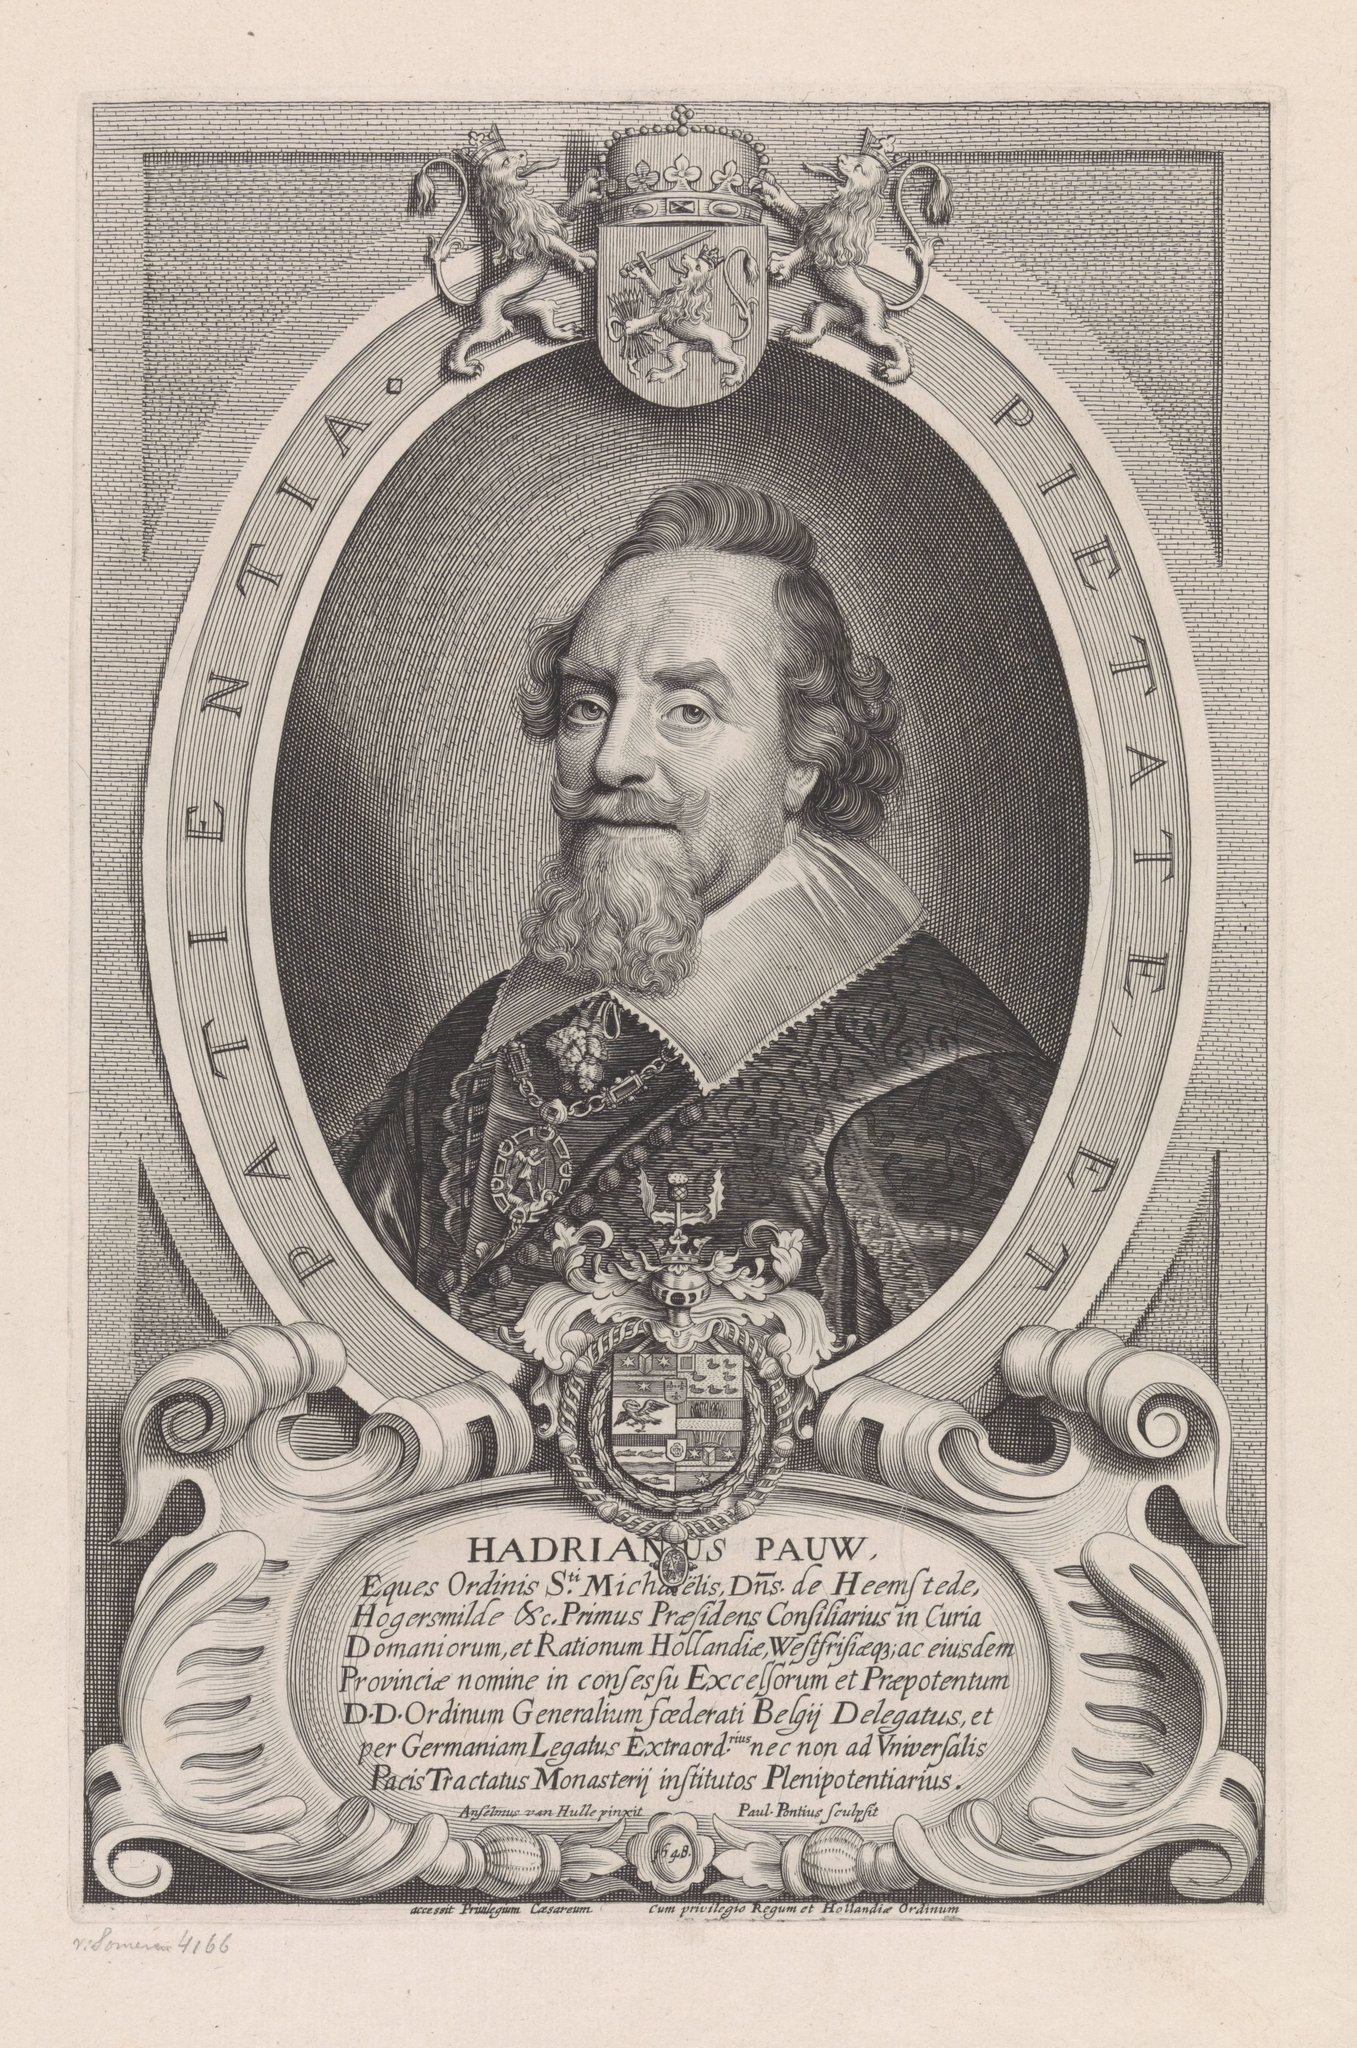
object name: print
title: Portret van Adriaen Pauw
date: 1648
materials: paper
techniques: engraving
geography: antwerp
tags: amsterdam, the hague, politician, adriaen pauw (1585-1653), armorial bearing, heraldry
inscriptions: collector's mark: Lugt 2228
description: Prent ook opgenomen in: Pacificatores orbis christiani, sive Icones principum, ducum et legatorum, qui Monasterii atque Osnabrugæ pacem Europæ reconciliarunt (...). = Pronkbeelden der vorsten, en vredehandelaars. Rotterdam: Pieter van der Slaart, 1697.